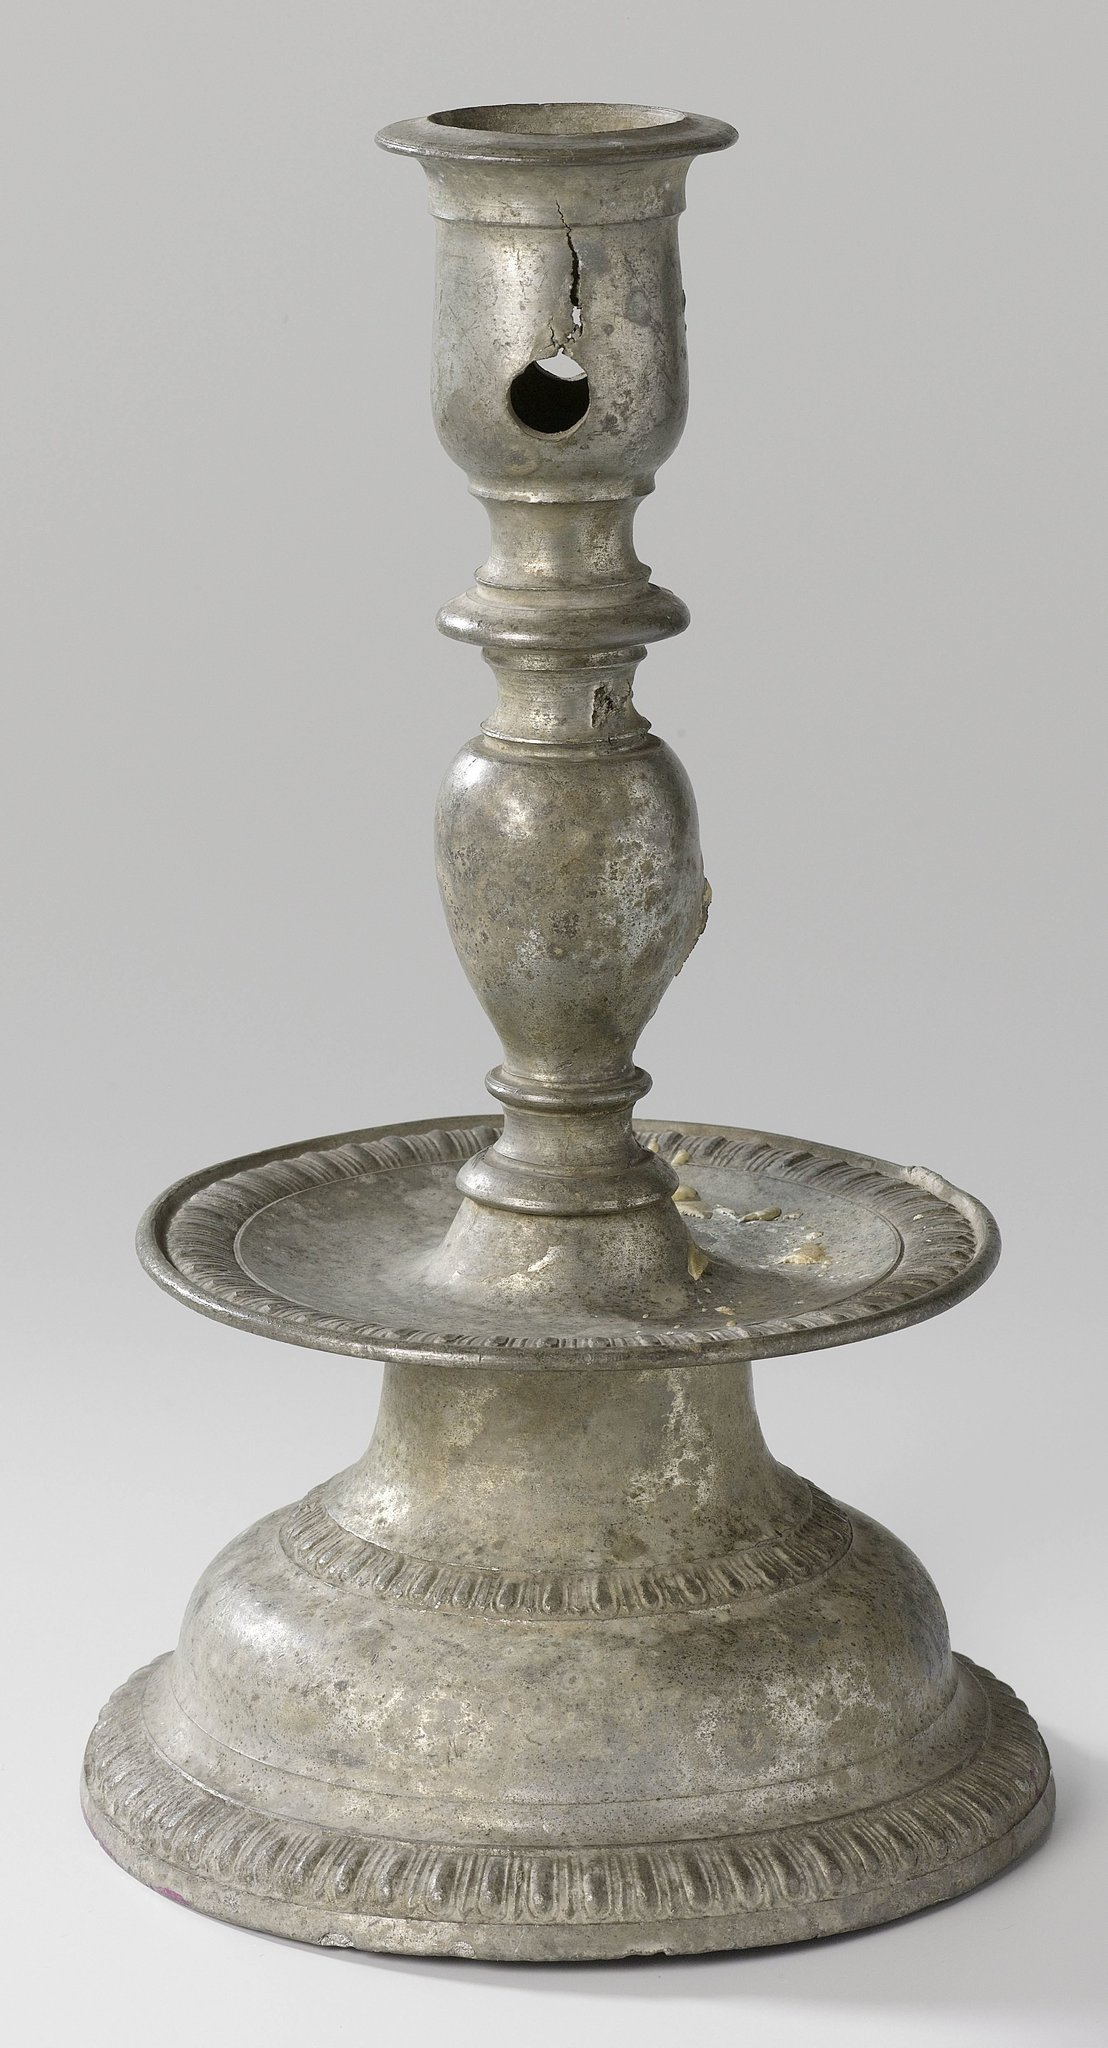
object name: flambouwkandelaar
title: Merchandise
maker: Anonymous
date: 1590-1596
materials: tin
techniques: casting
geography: netherlands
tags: willem barendsz., amsterdam, jacob van heemskerck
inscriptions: mark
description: Barentsz and his crew were en route to China, and therefore brought along goods they could use to conduct trade there. They obviously expected these pewter candlesticks to be in demand in Asia.